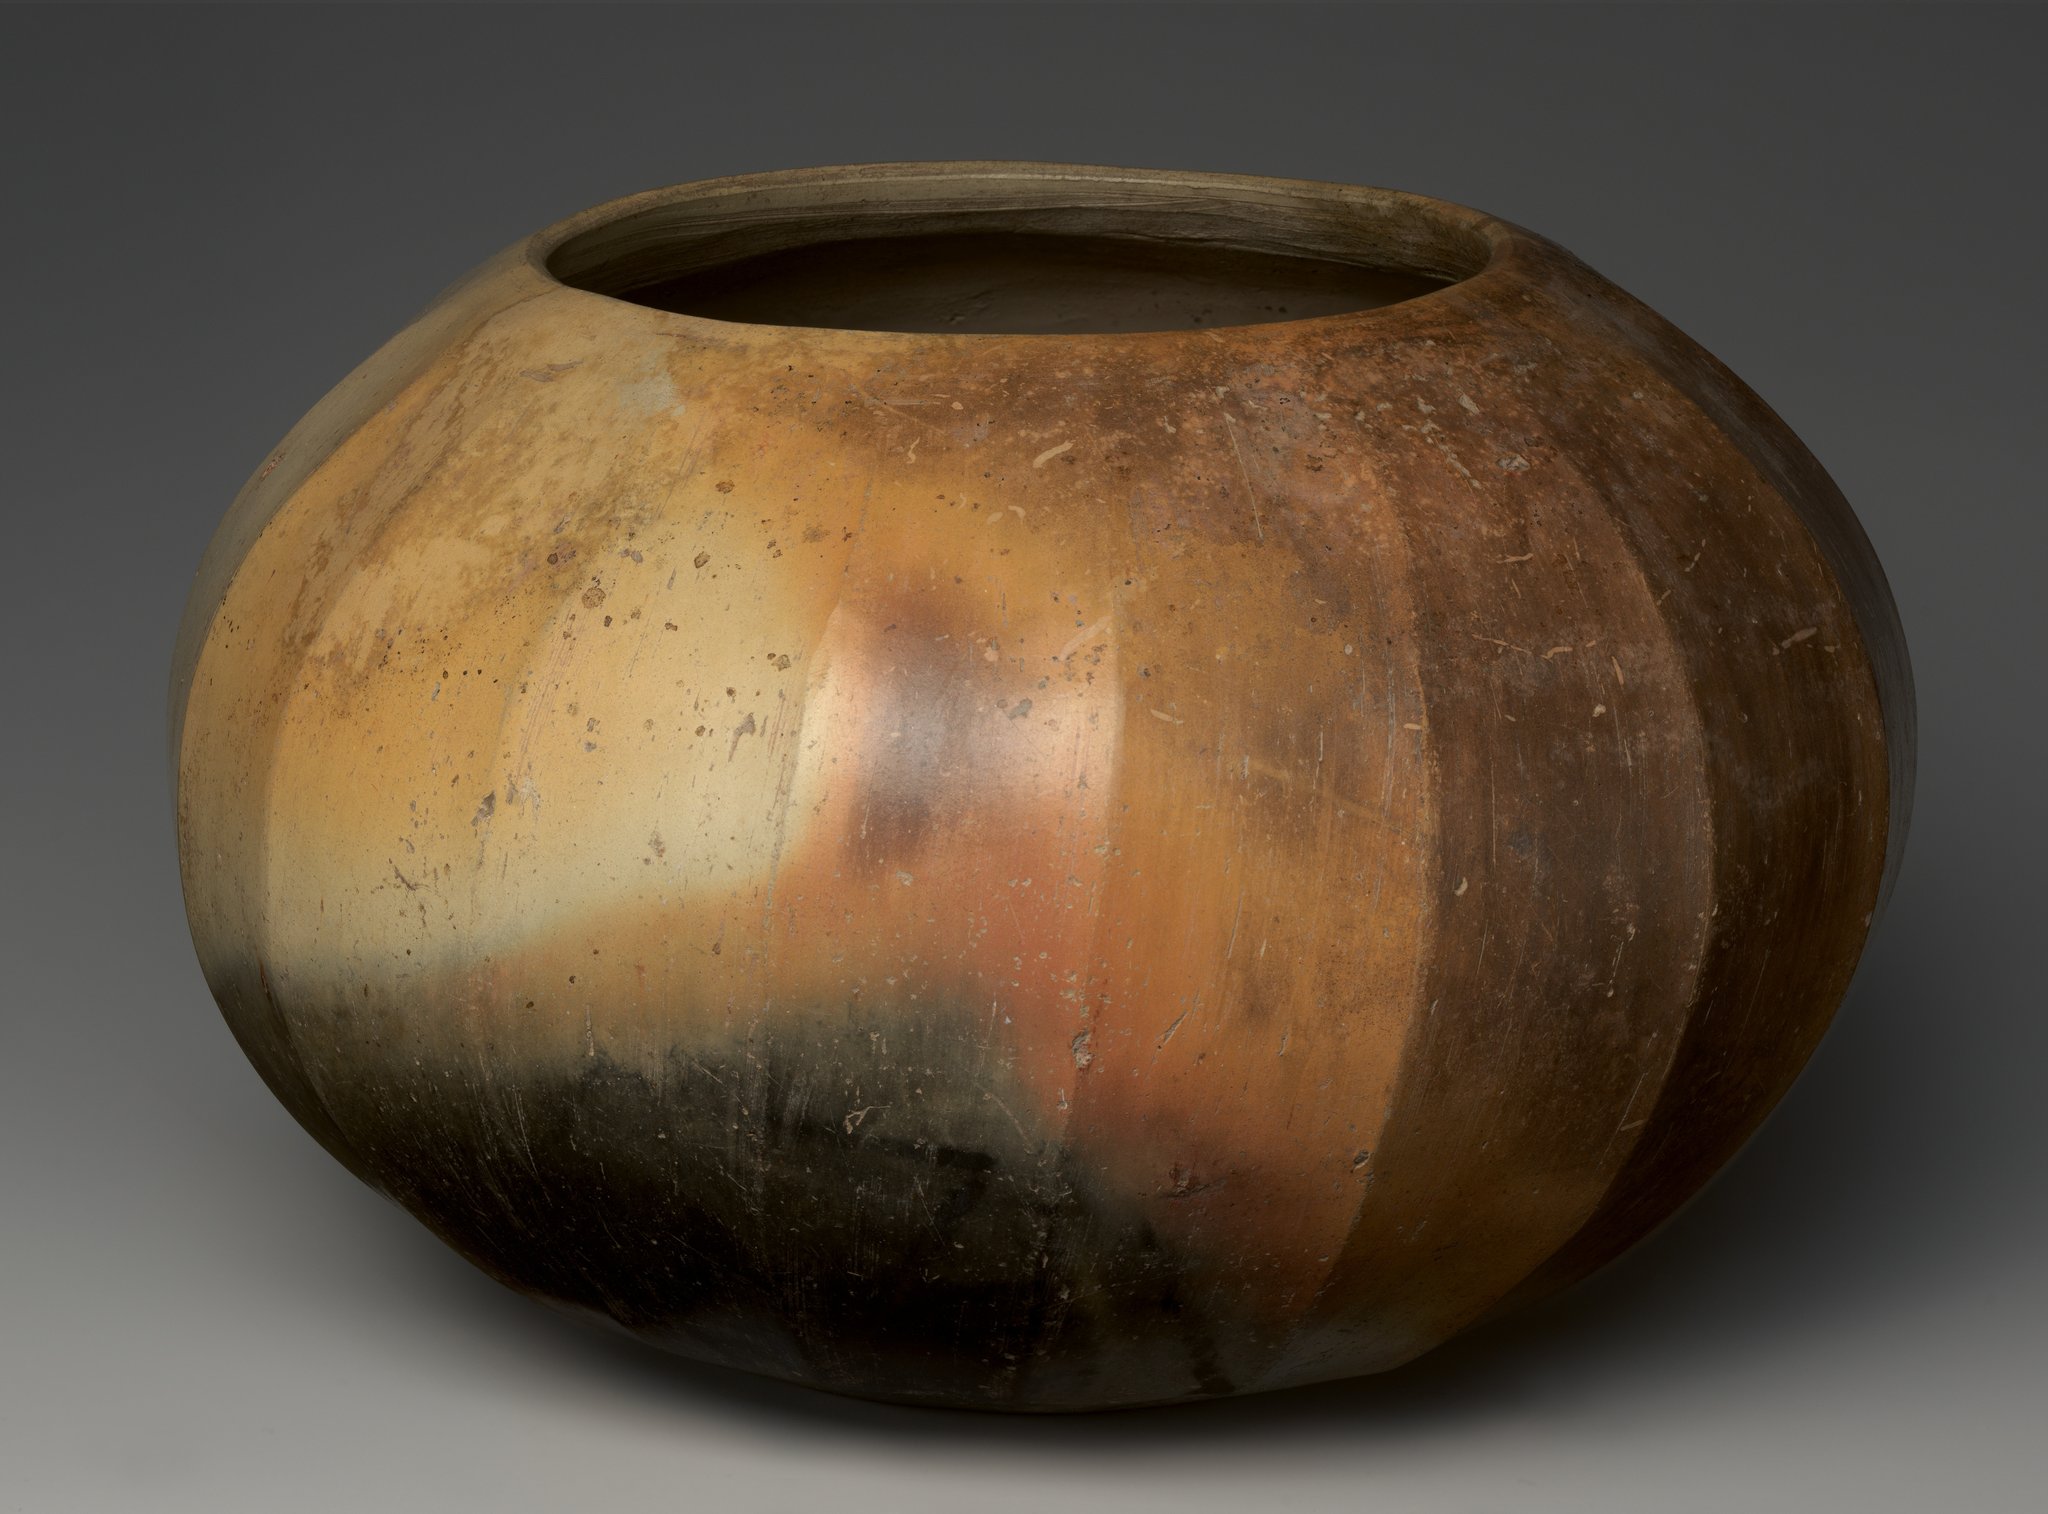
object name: bowl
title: Bowl (Tecomate)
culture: olmec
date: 1200-801 BCE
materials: ceramic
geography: mexico